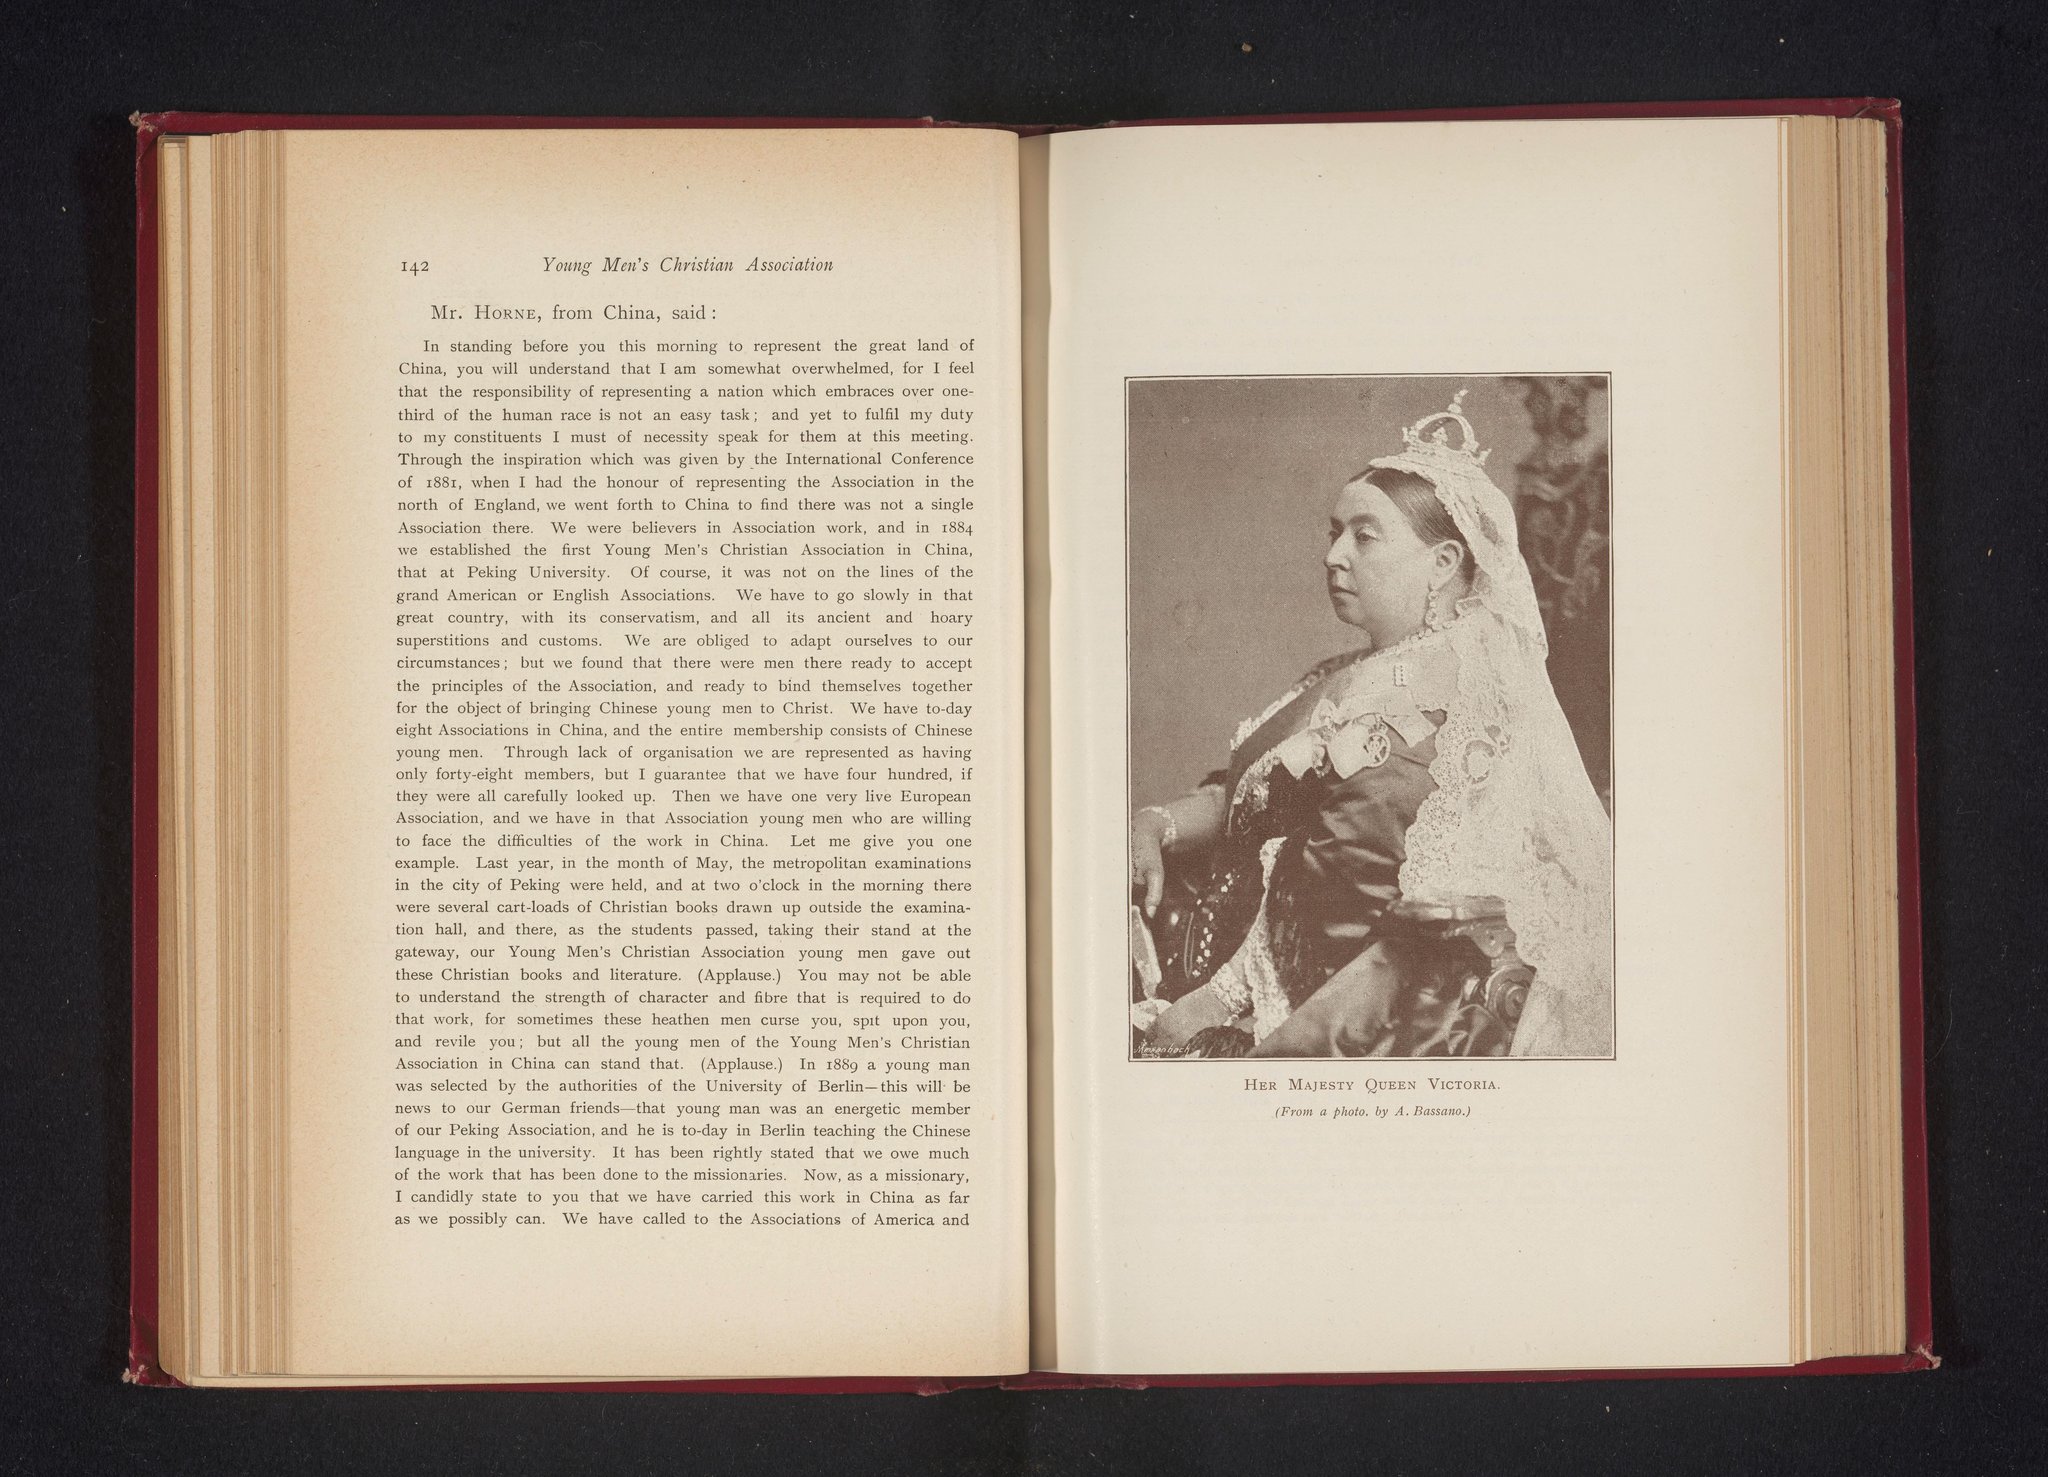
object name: photomechanical print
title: Portret van koningin Victoria van Engeland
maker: bassano (fotograaf)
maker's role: fotograaf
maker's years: 1829-1913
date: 1890-1895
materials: paper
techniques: autotype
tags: victoria (koningin van het verenigd koninkrijk en keizerin van india), historical persons - bb - woman